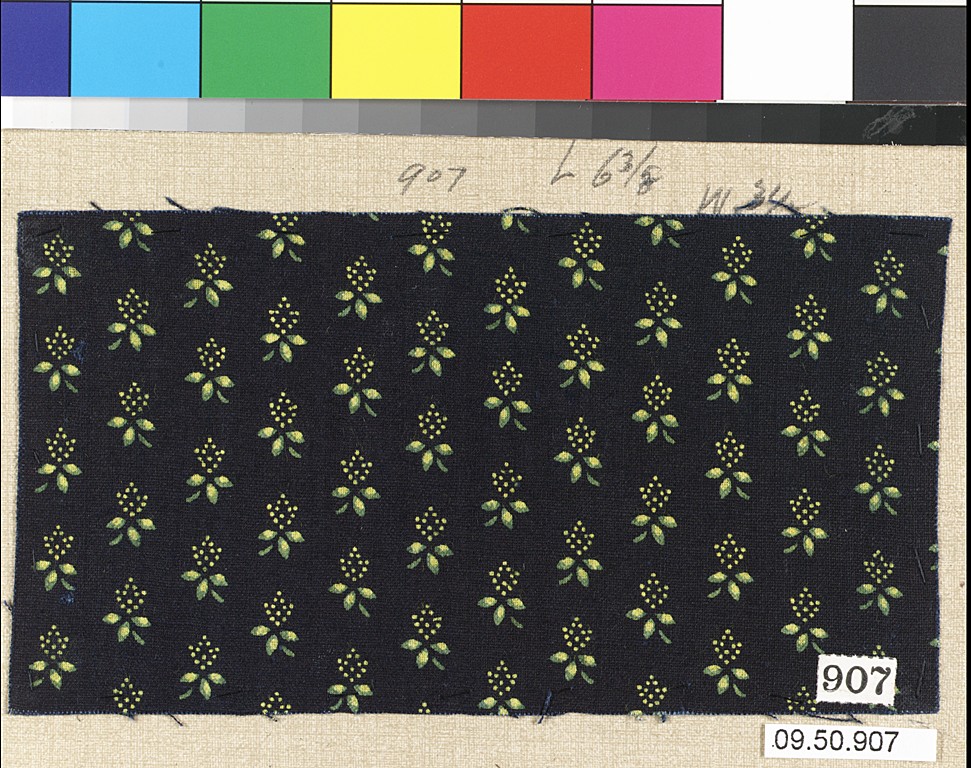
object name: piece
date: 1801-1900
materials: cotton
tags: leaves